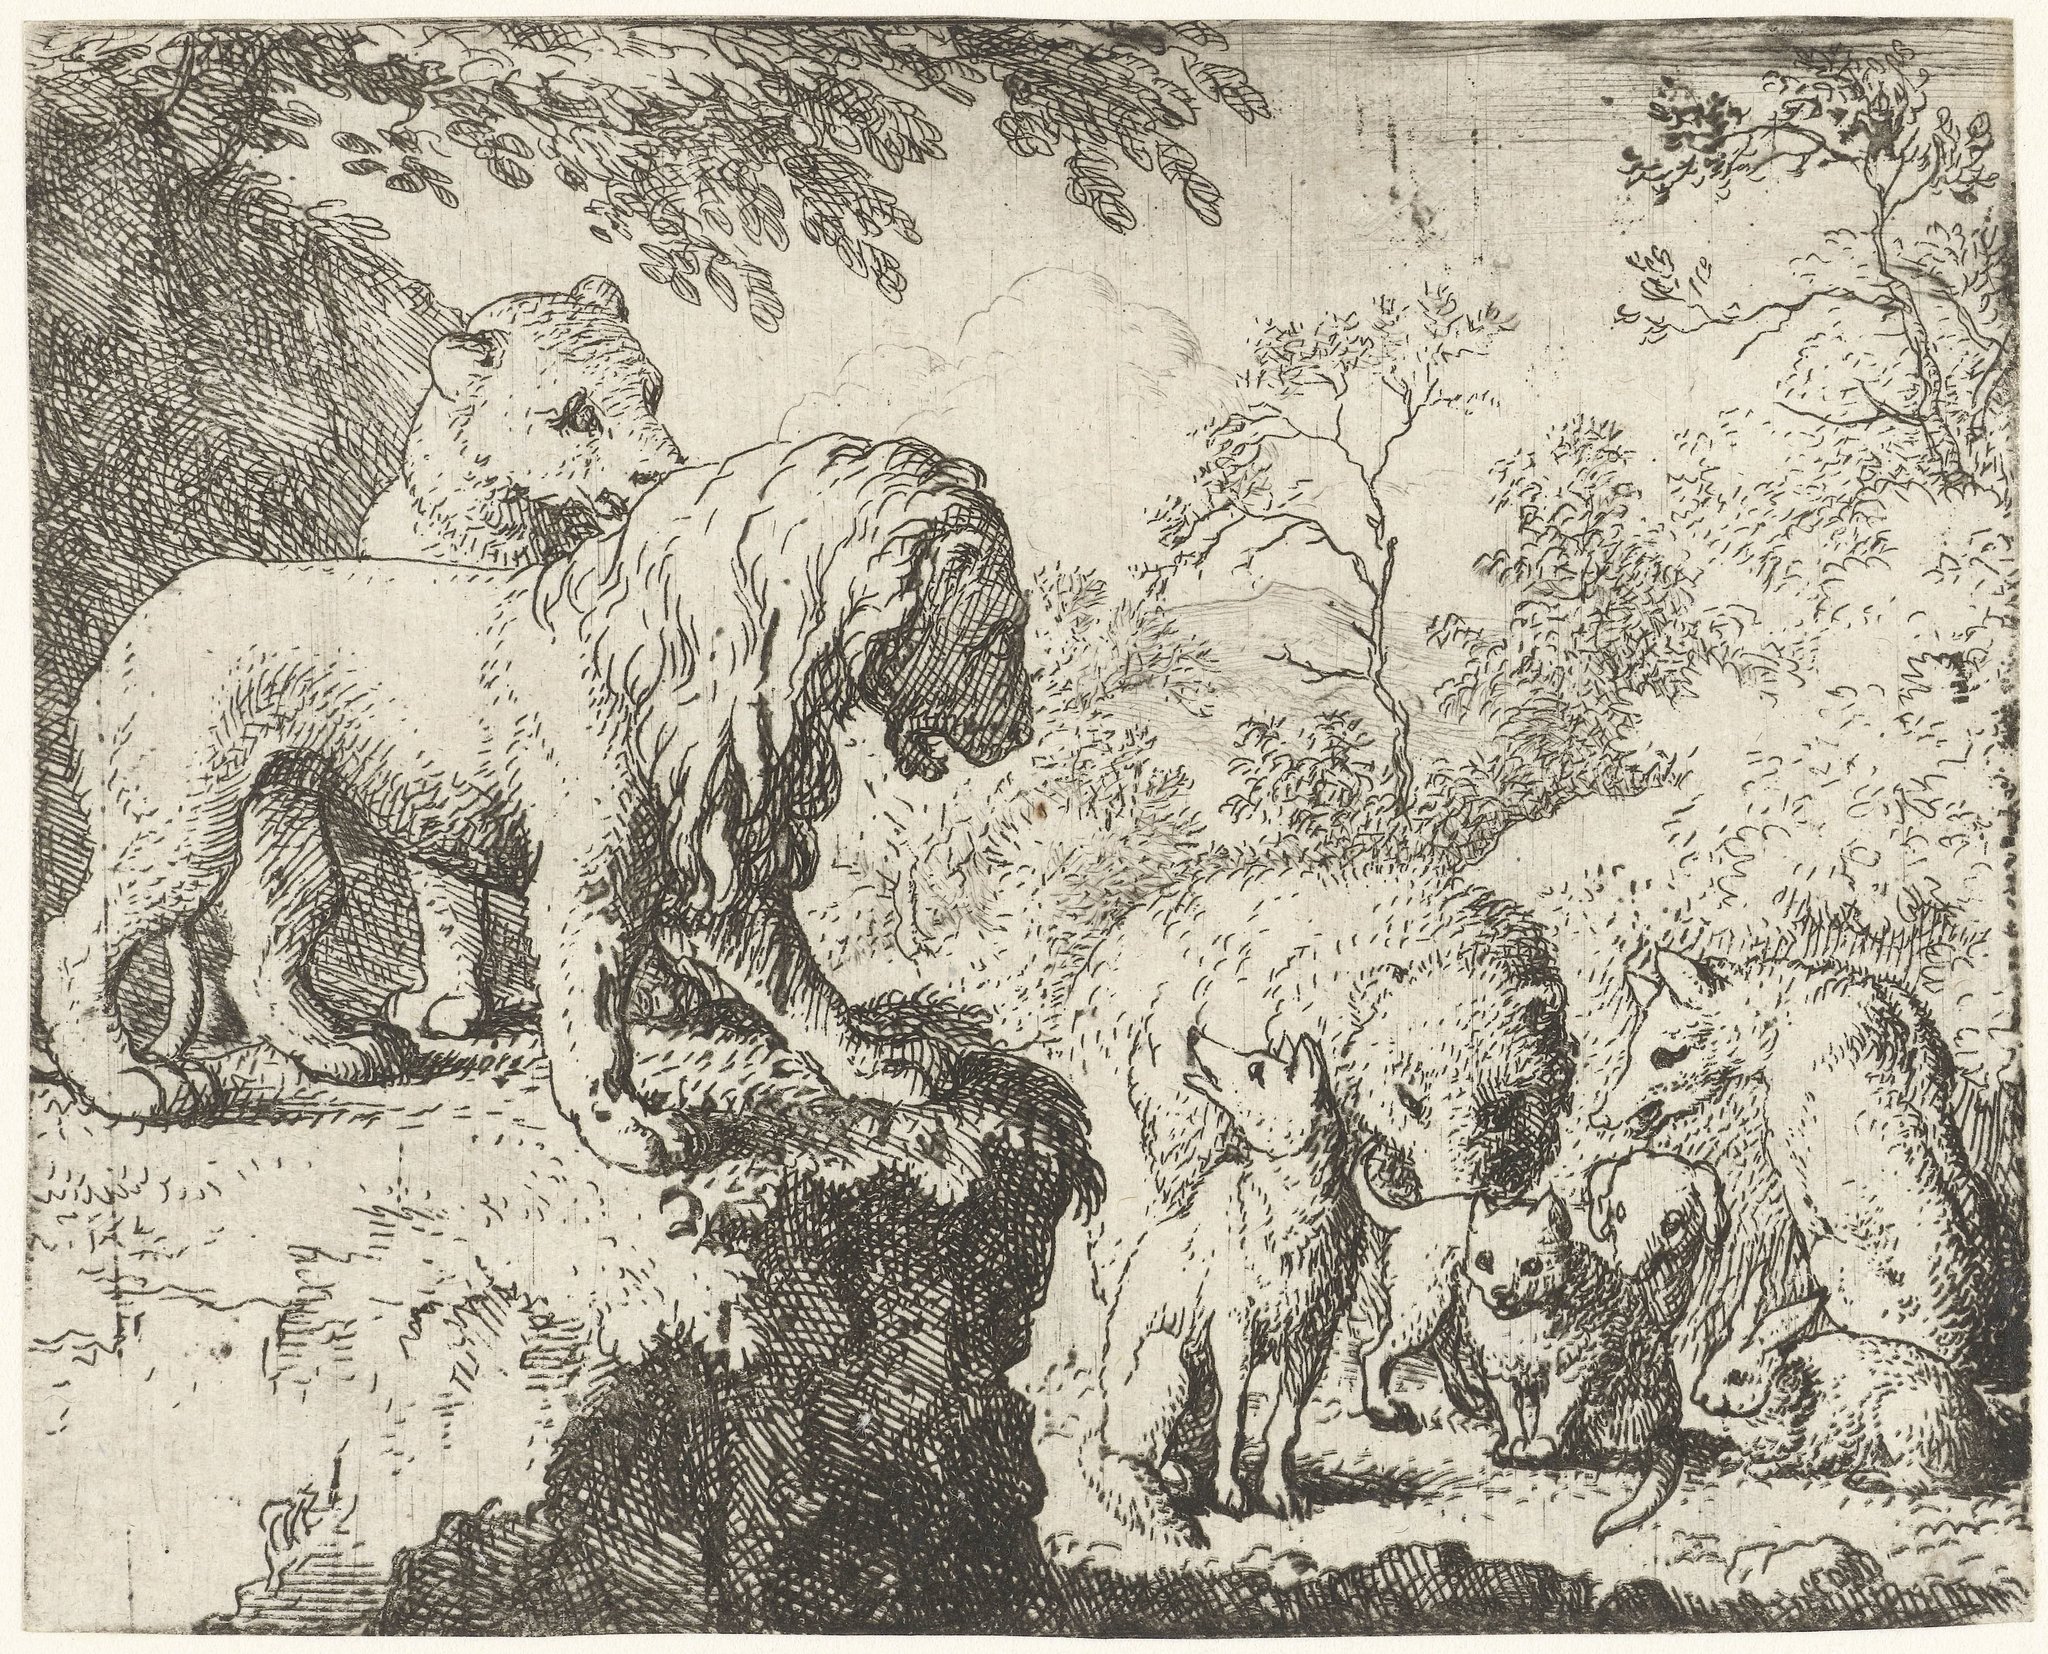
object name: print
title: Reinaert de vos wordt vrijgesproken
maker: allaert van everdingen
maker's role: draughtsman, painter, print maker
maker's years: 1621-1675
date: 1665-1675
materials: paper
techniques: etching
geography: netherlands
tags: fable of reynard the fox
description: Koning Nobel de leeuw, met naast hem de koningin, spreekt vanaf een verhoging de dieren toe.